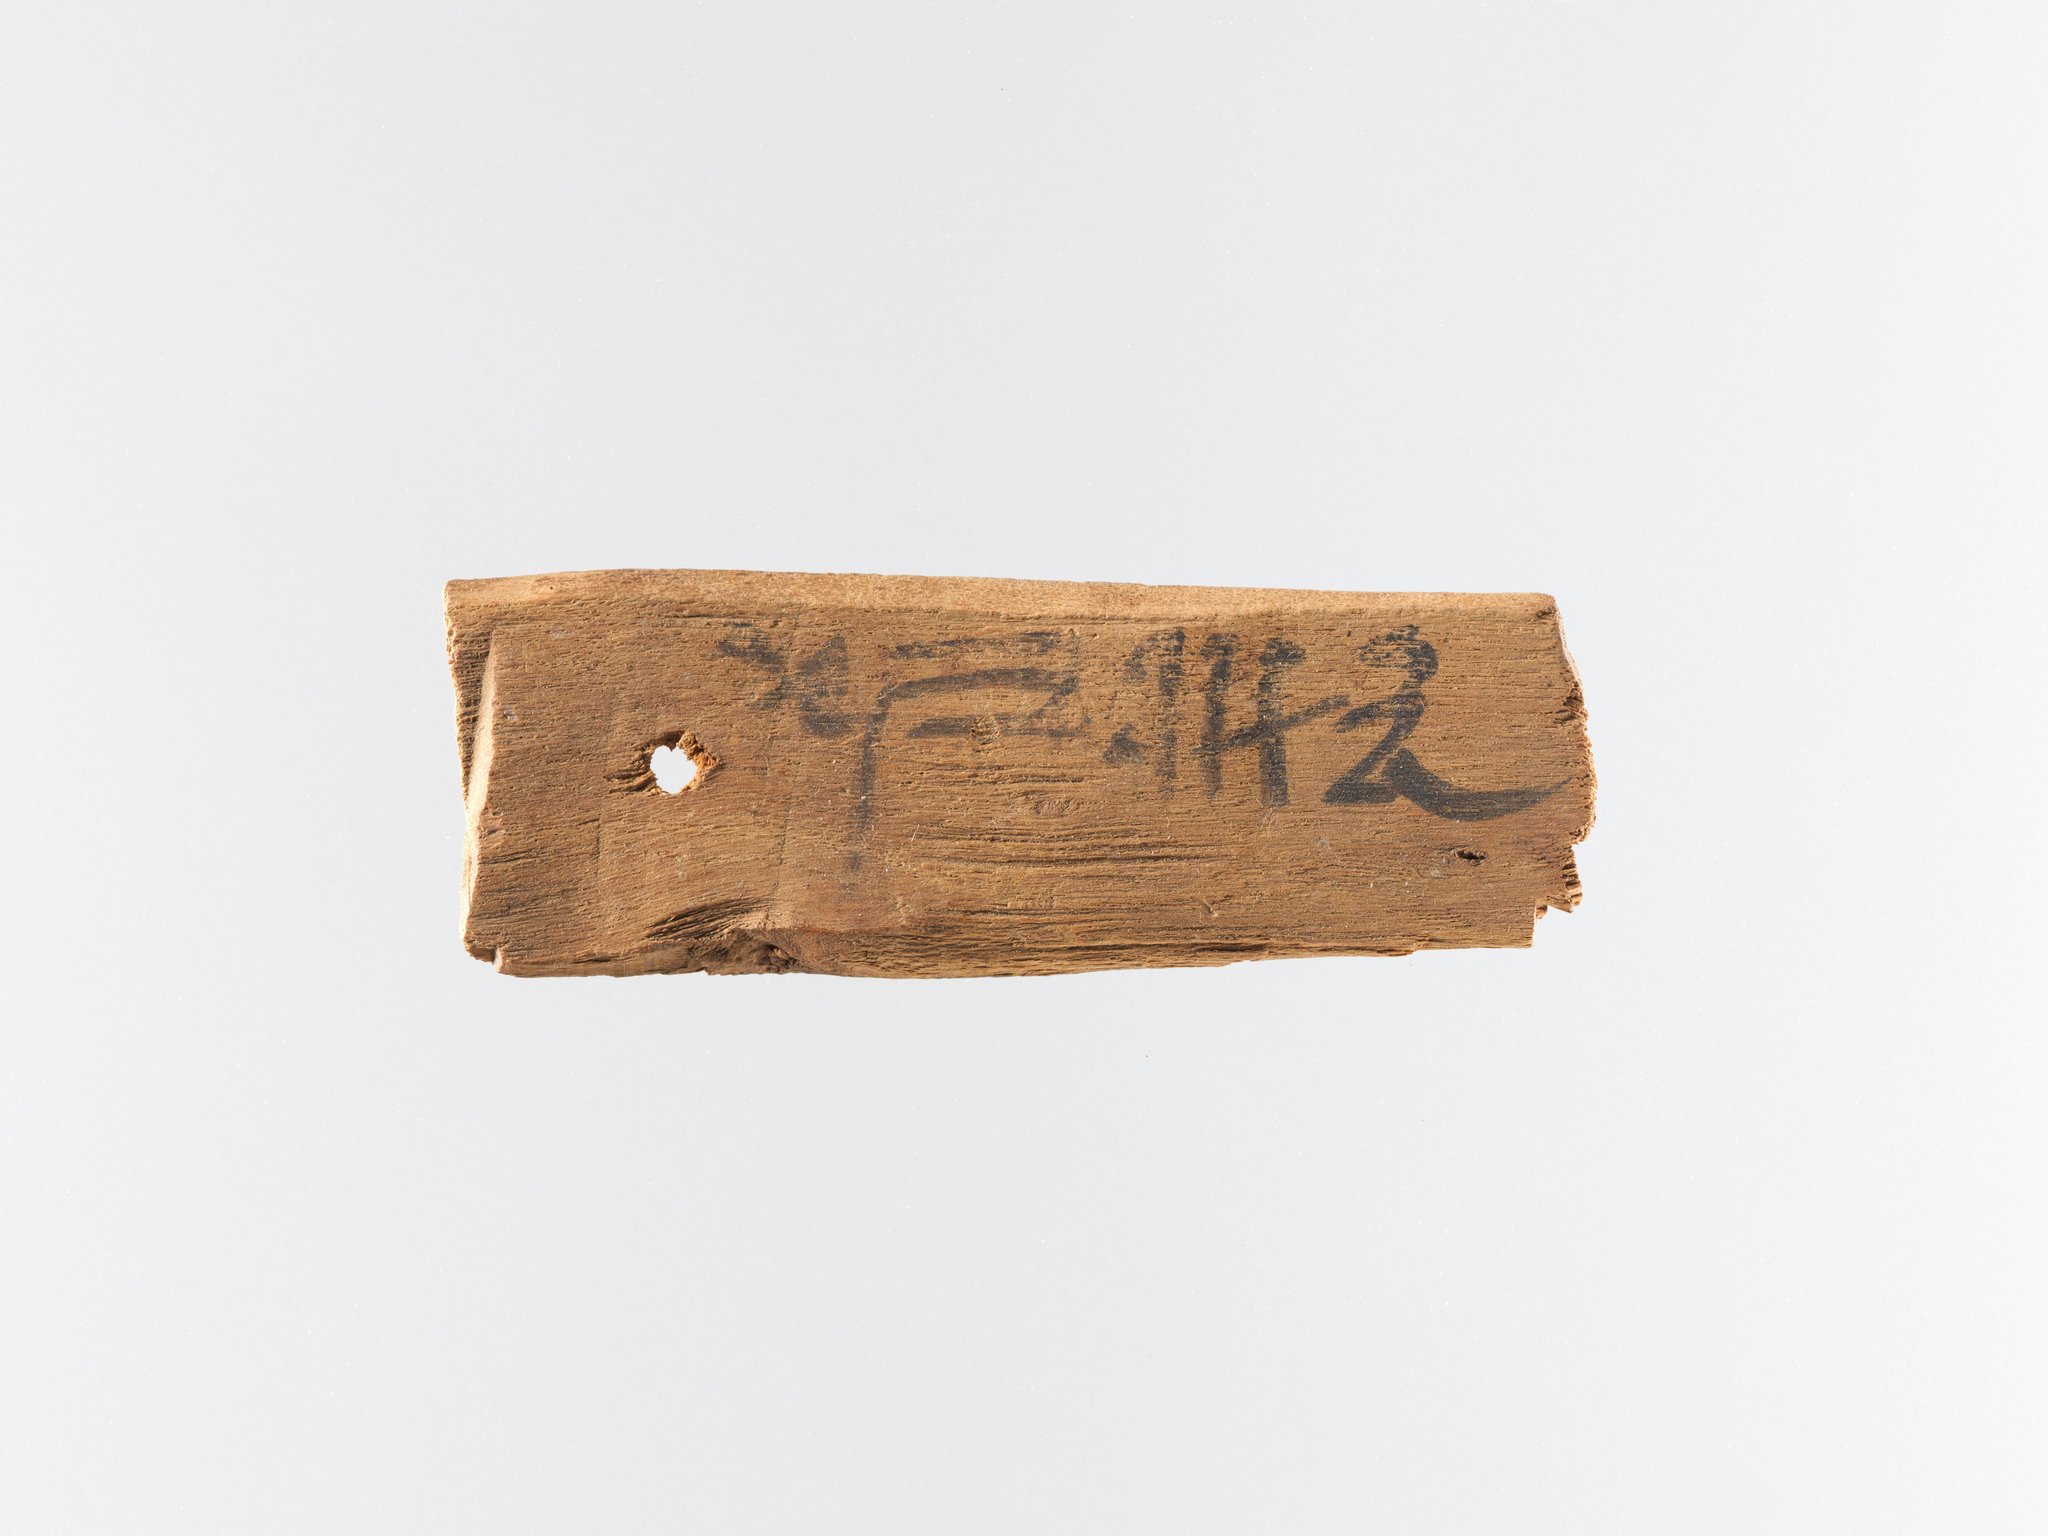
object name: mummy label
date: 1070-343 BCE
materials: wood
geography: egypt